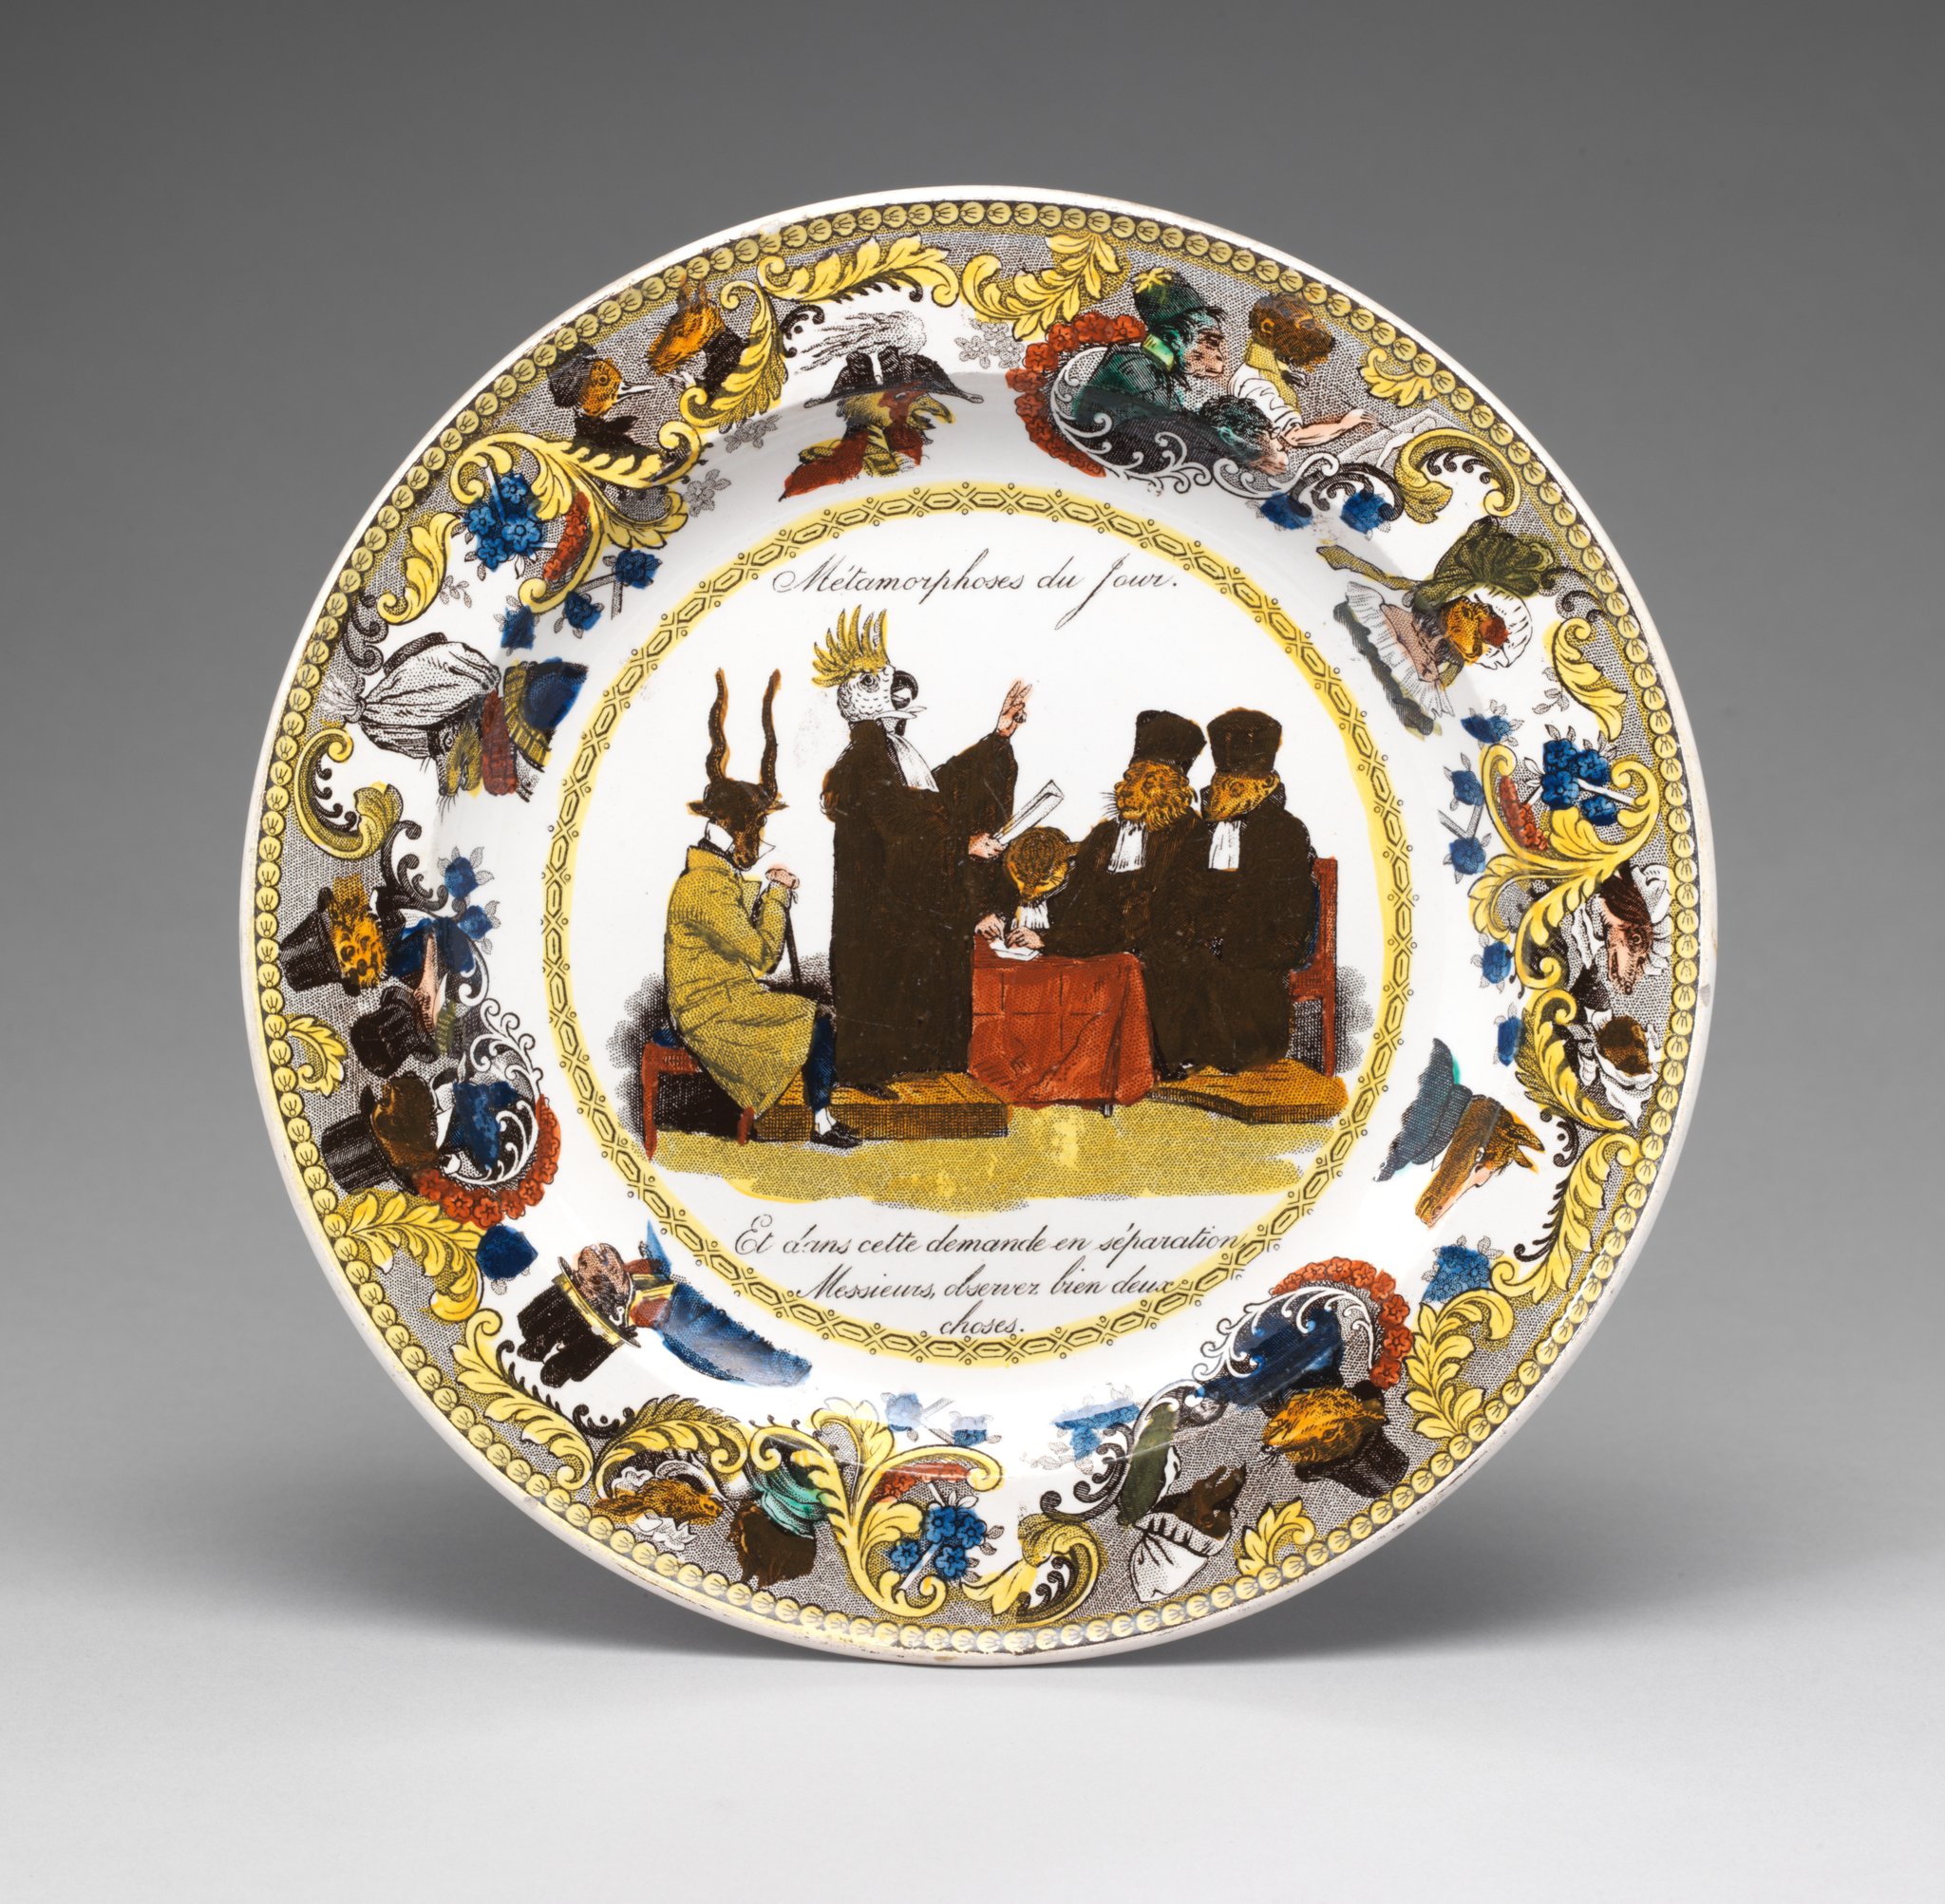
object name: plate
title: Plate with a scene from Métamorphoses du Jour (plate 37)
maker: creil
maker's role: manufactory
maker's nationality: french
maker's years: 1797-1895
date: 1830-1840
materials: earthenware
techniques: glazing, transfer